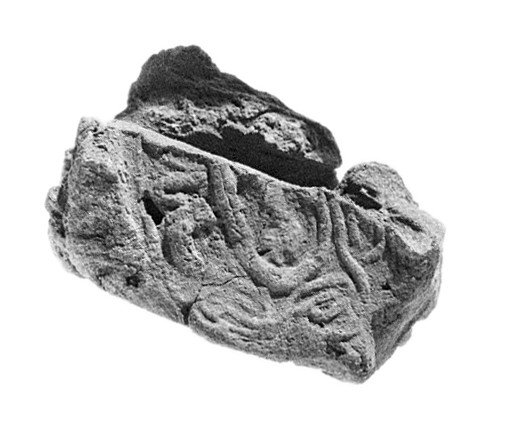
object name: sealing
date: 1981-1640 BCE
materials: mud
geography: egypt